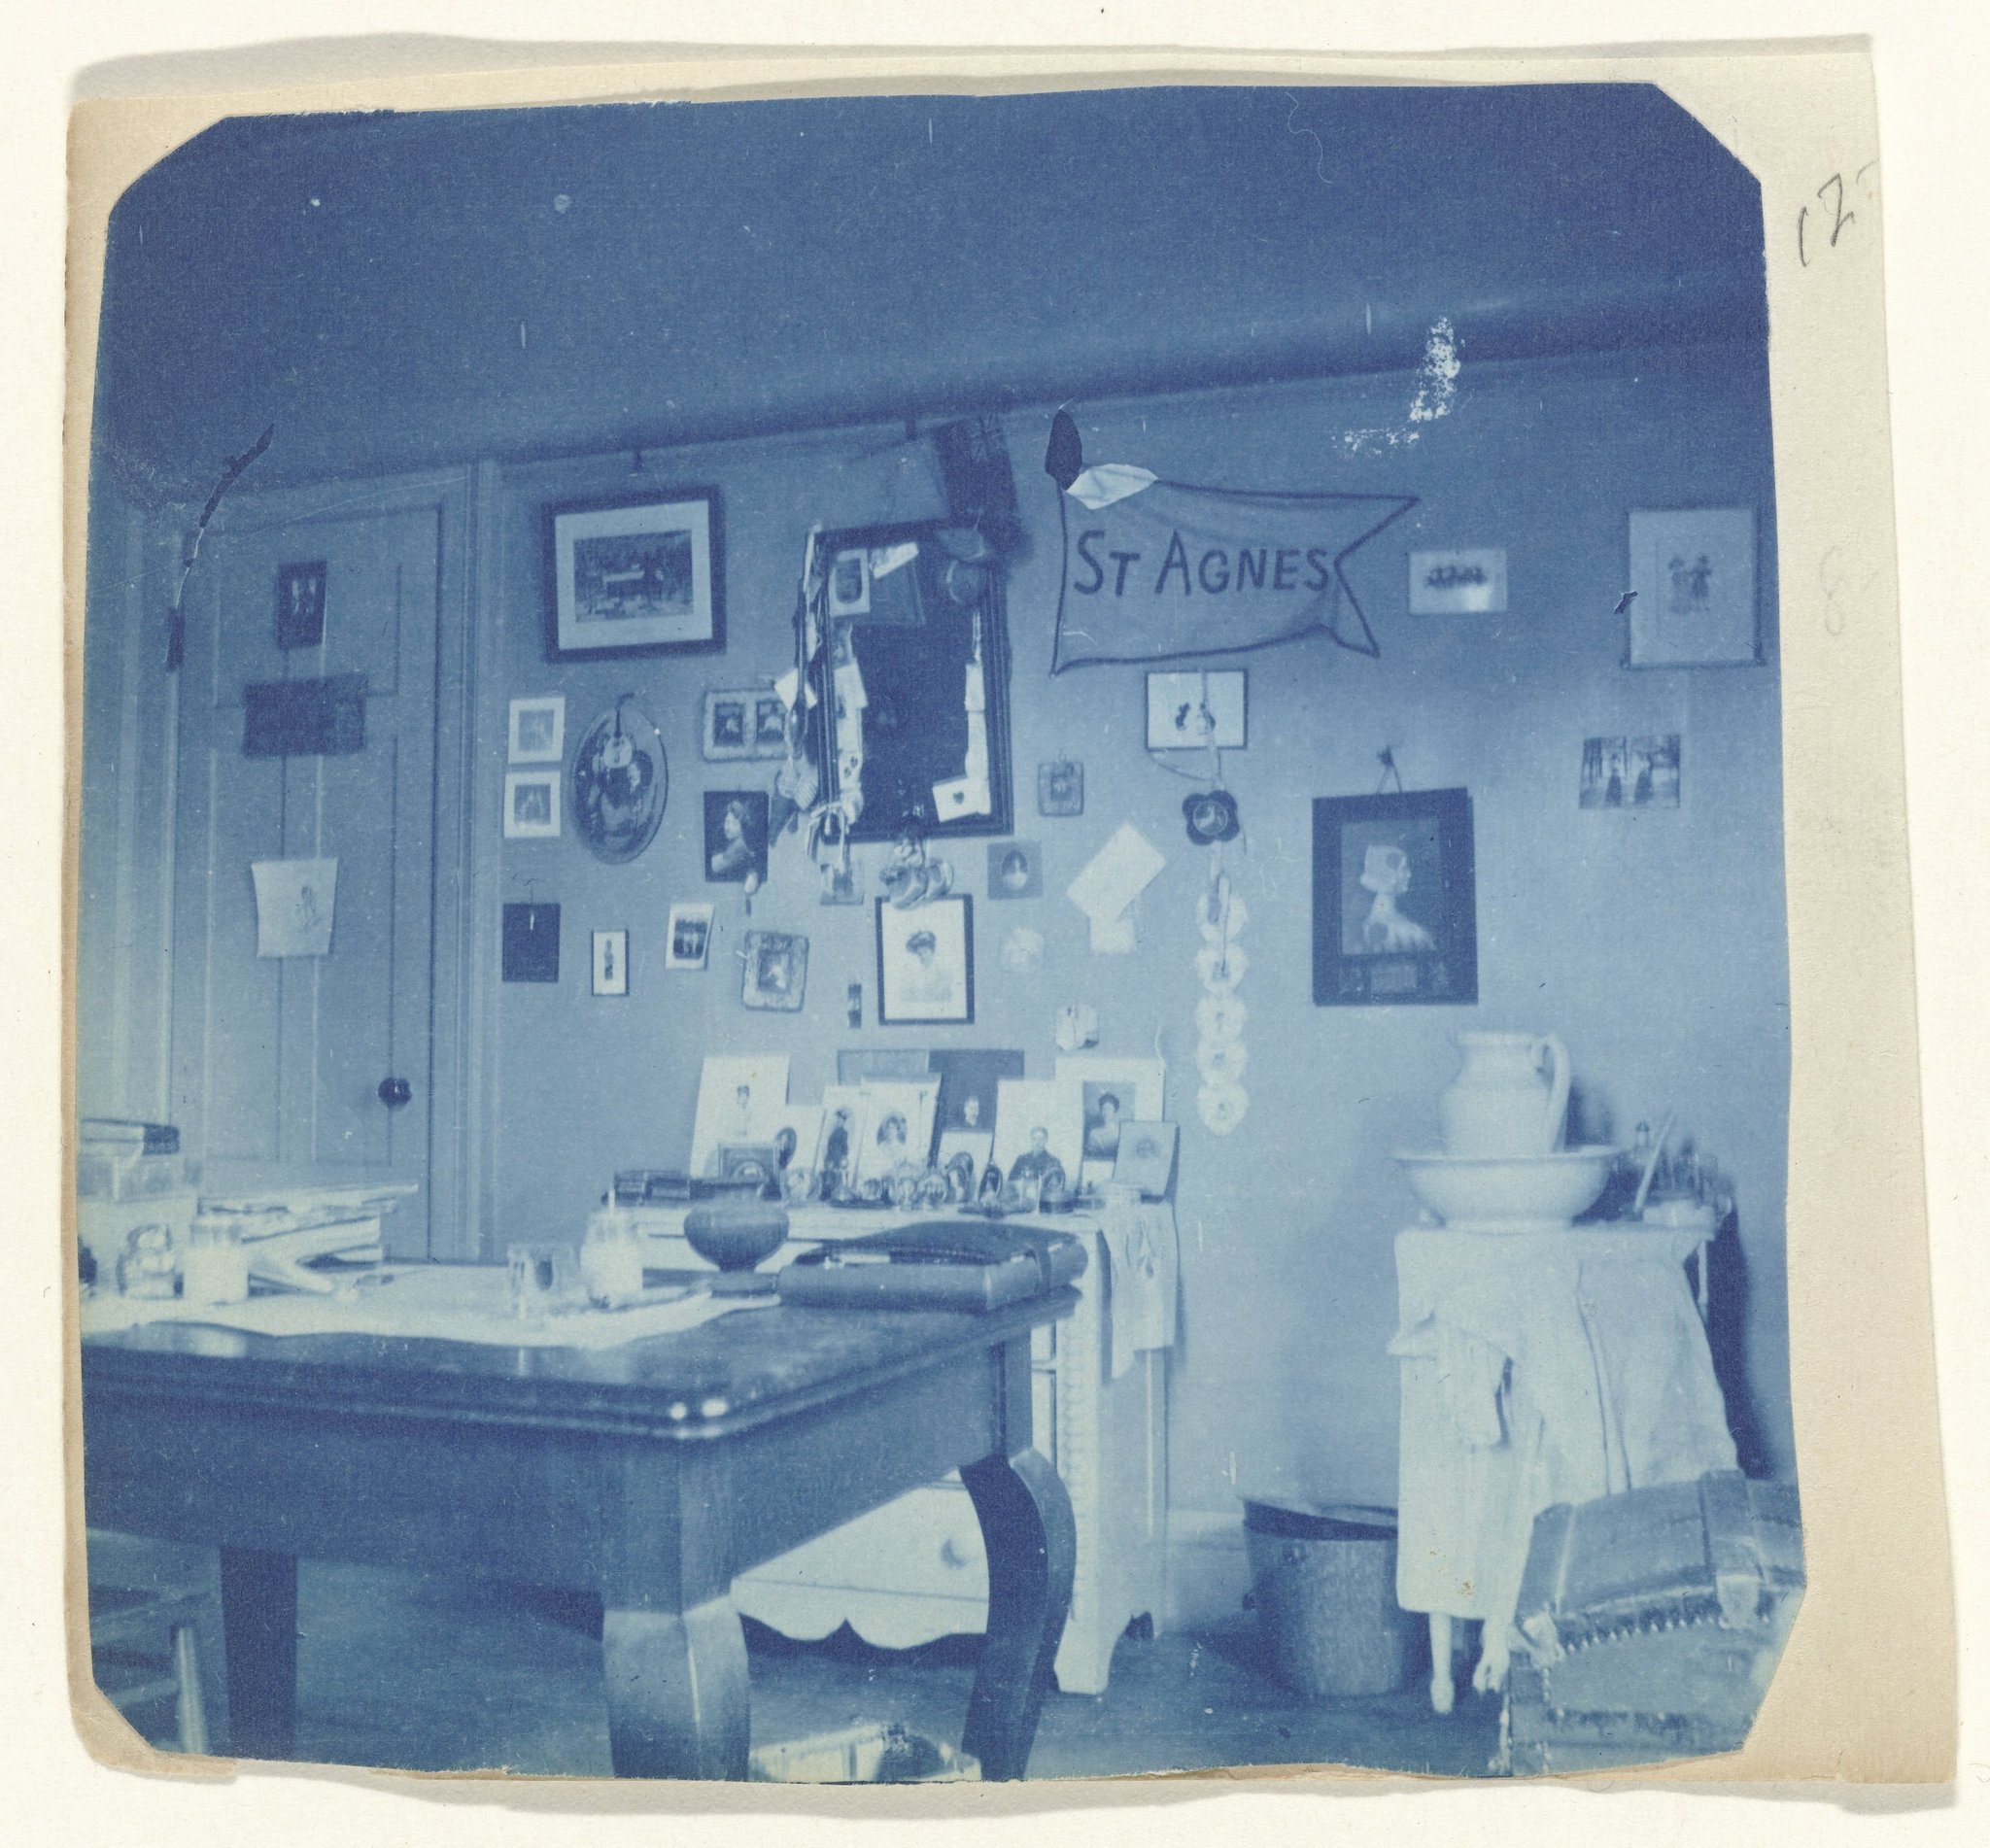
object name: photograph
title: Interieur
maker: Anonymous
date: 1900-1910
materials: paper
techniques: cyanotype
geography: united states